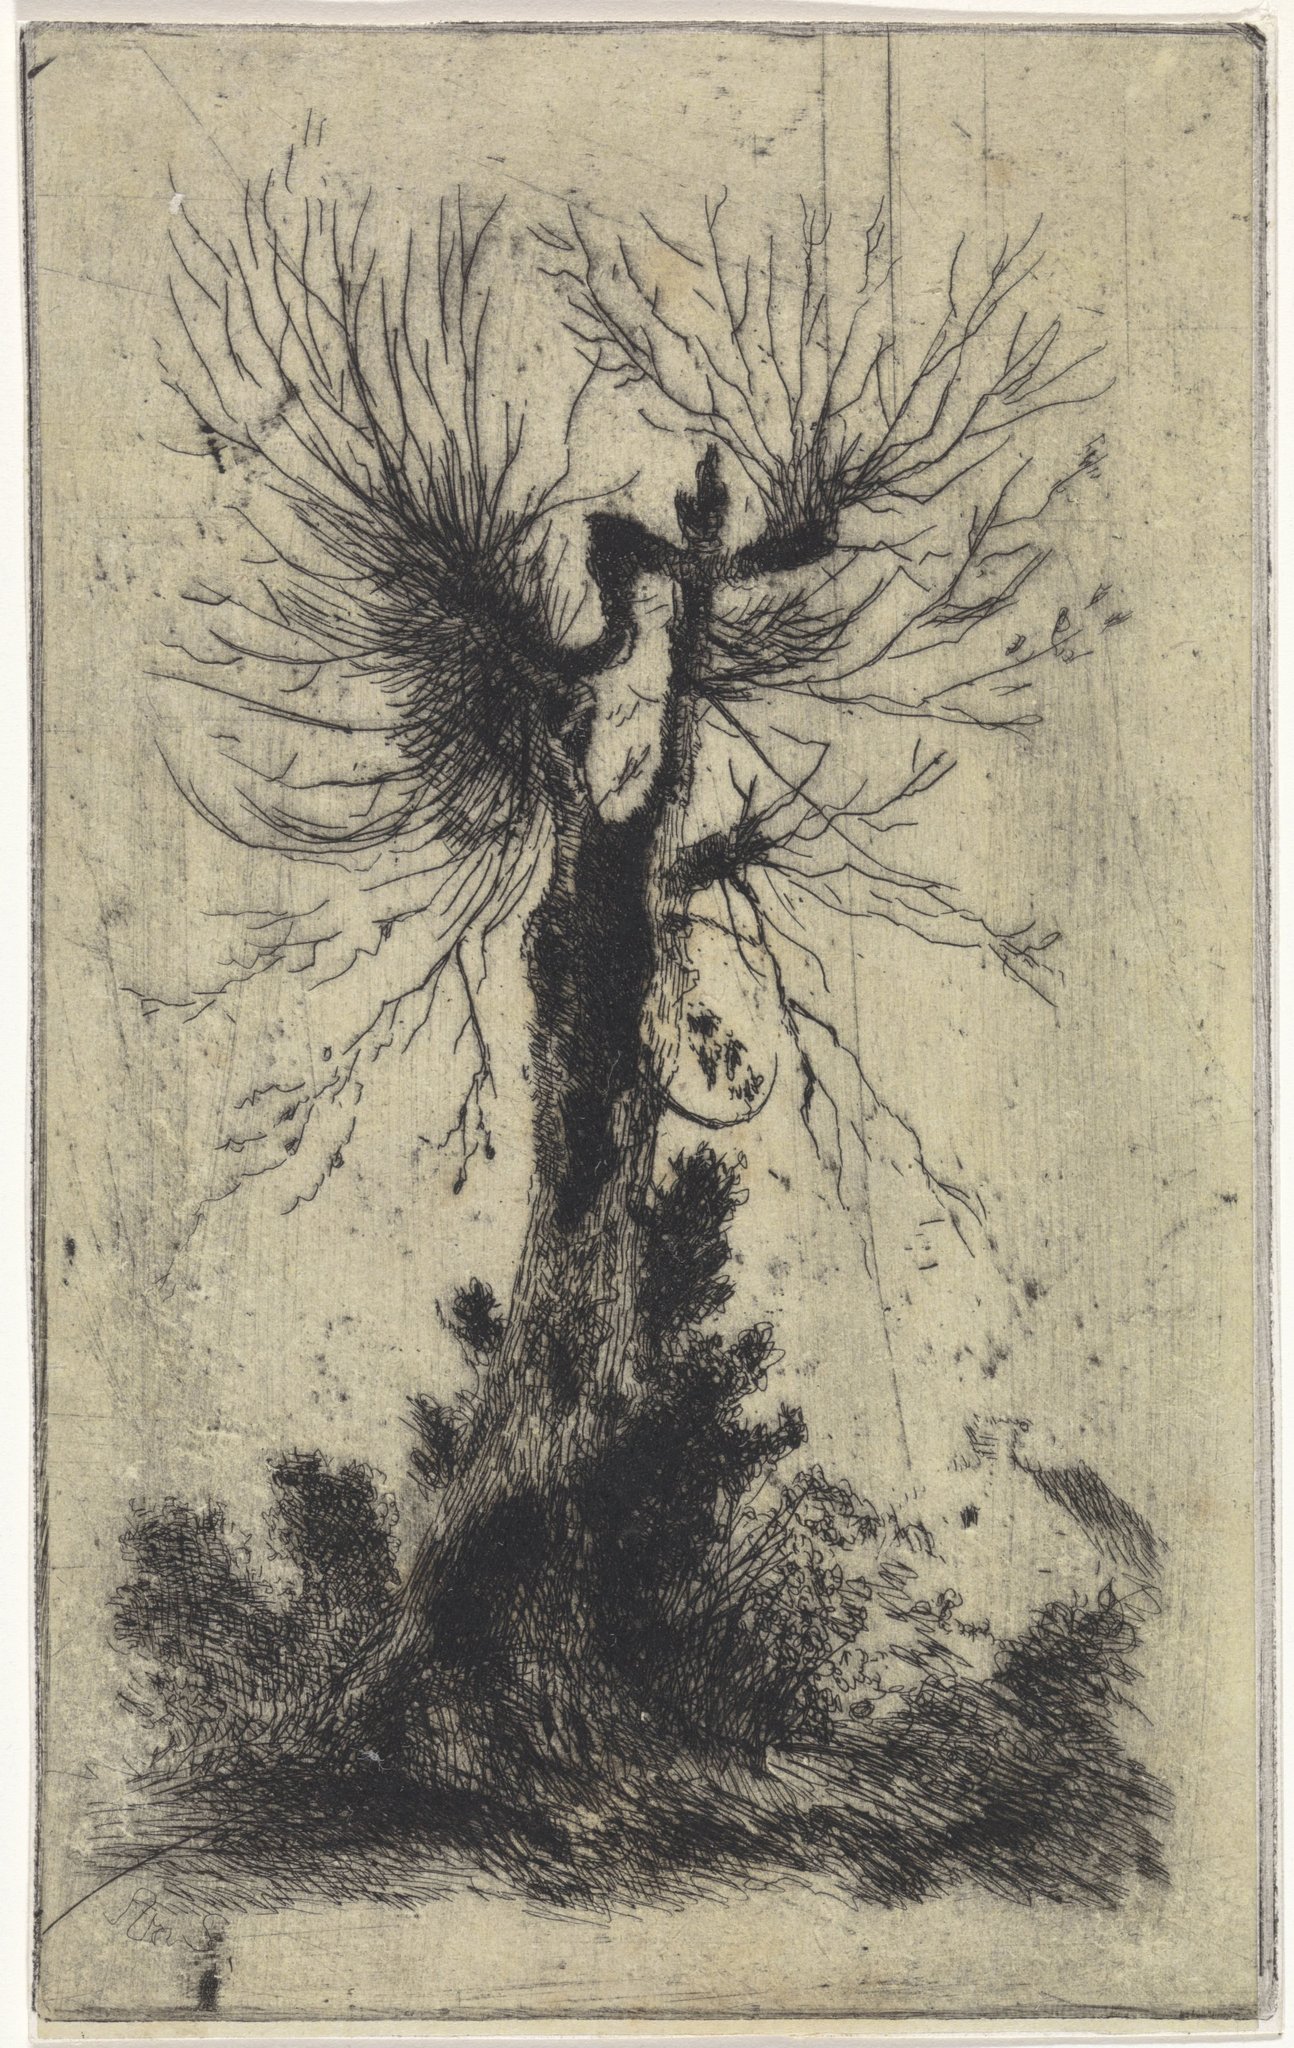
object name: print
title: Boomstudie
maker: arnoud schaepkens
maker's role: print maker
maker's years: 1816-1904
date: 1855-1904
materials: paper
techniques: drypoint, etching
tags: trees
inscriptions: collector's mark: Lugt 2228